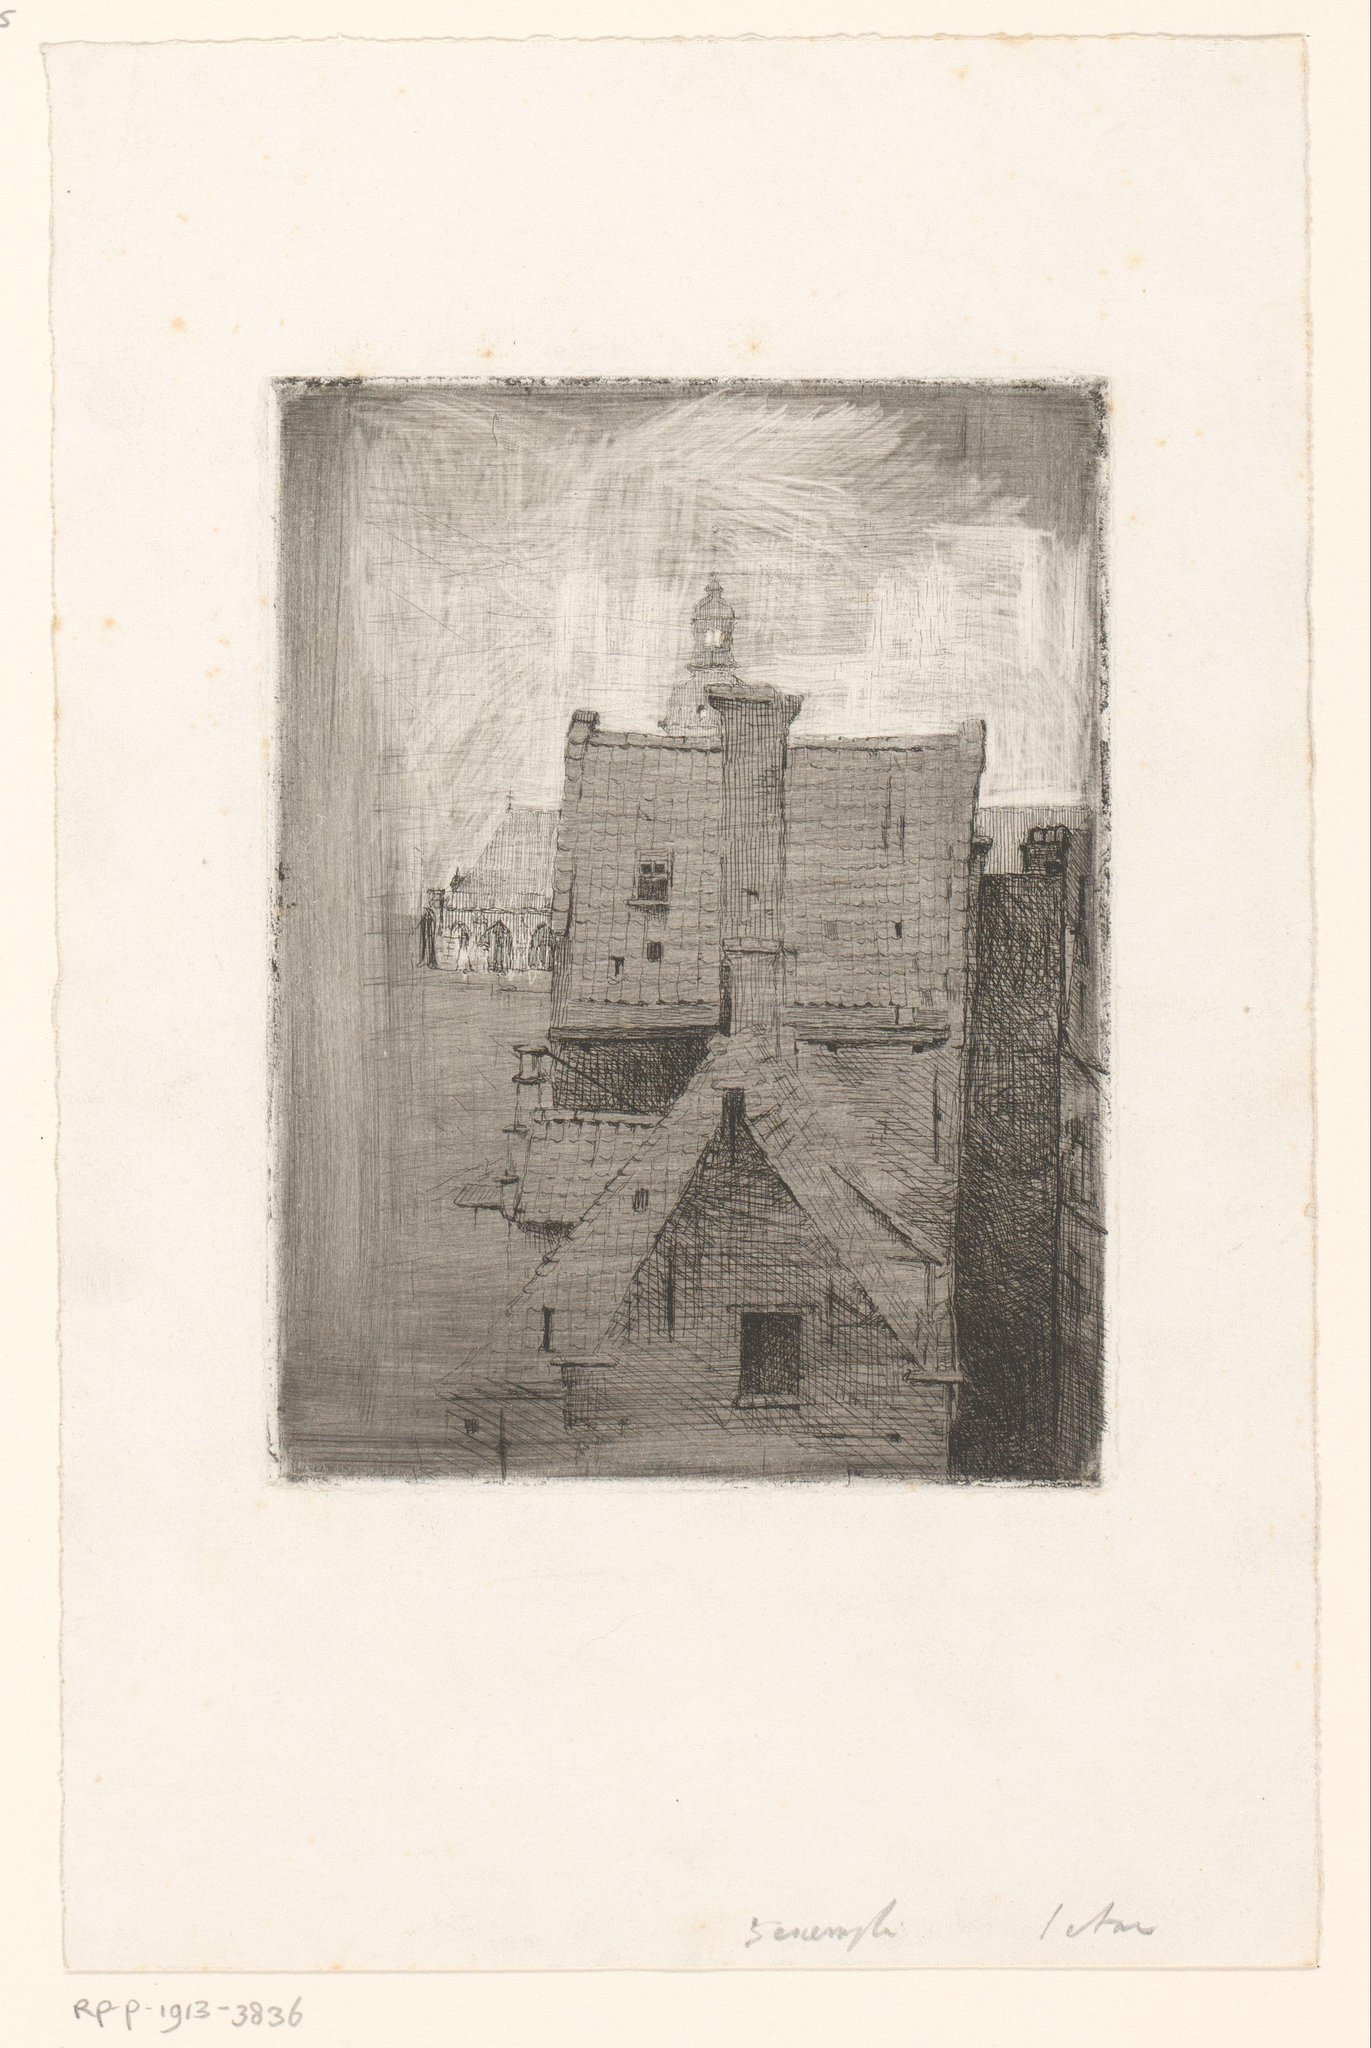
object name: print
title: Gezicht op daken met een schoorsteen, op de achtergrond een kerk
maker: piet verhaert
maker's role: print maker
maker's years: 1852-1908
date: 1862-1908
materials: paper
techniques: etching, intaglio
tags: roof (of house or building), housing, church (exterior)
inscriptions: collector's mark: Lugt 2228, inscription: ‘3 exempl 1 eta’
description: Mogelijk gaat het om de Sint-Pauluskerk te Antwerpen.